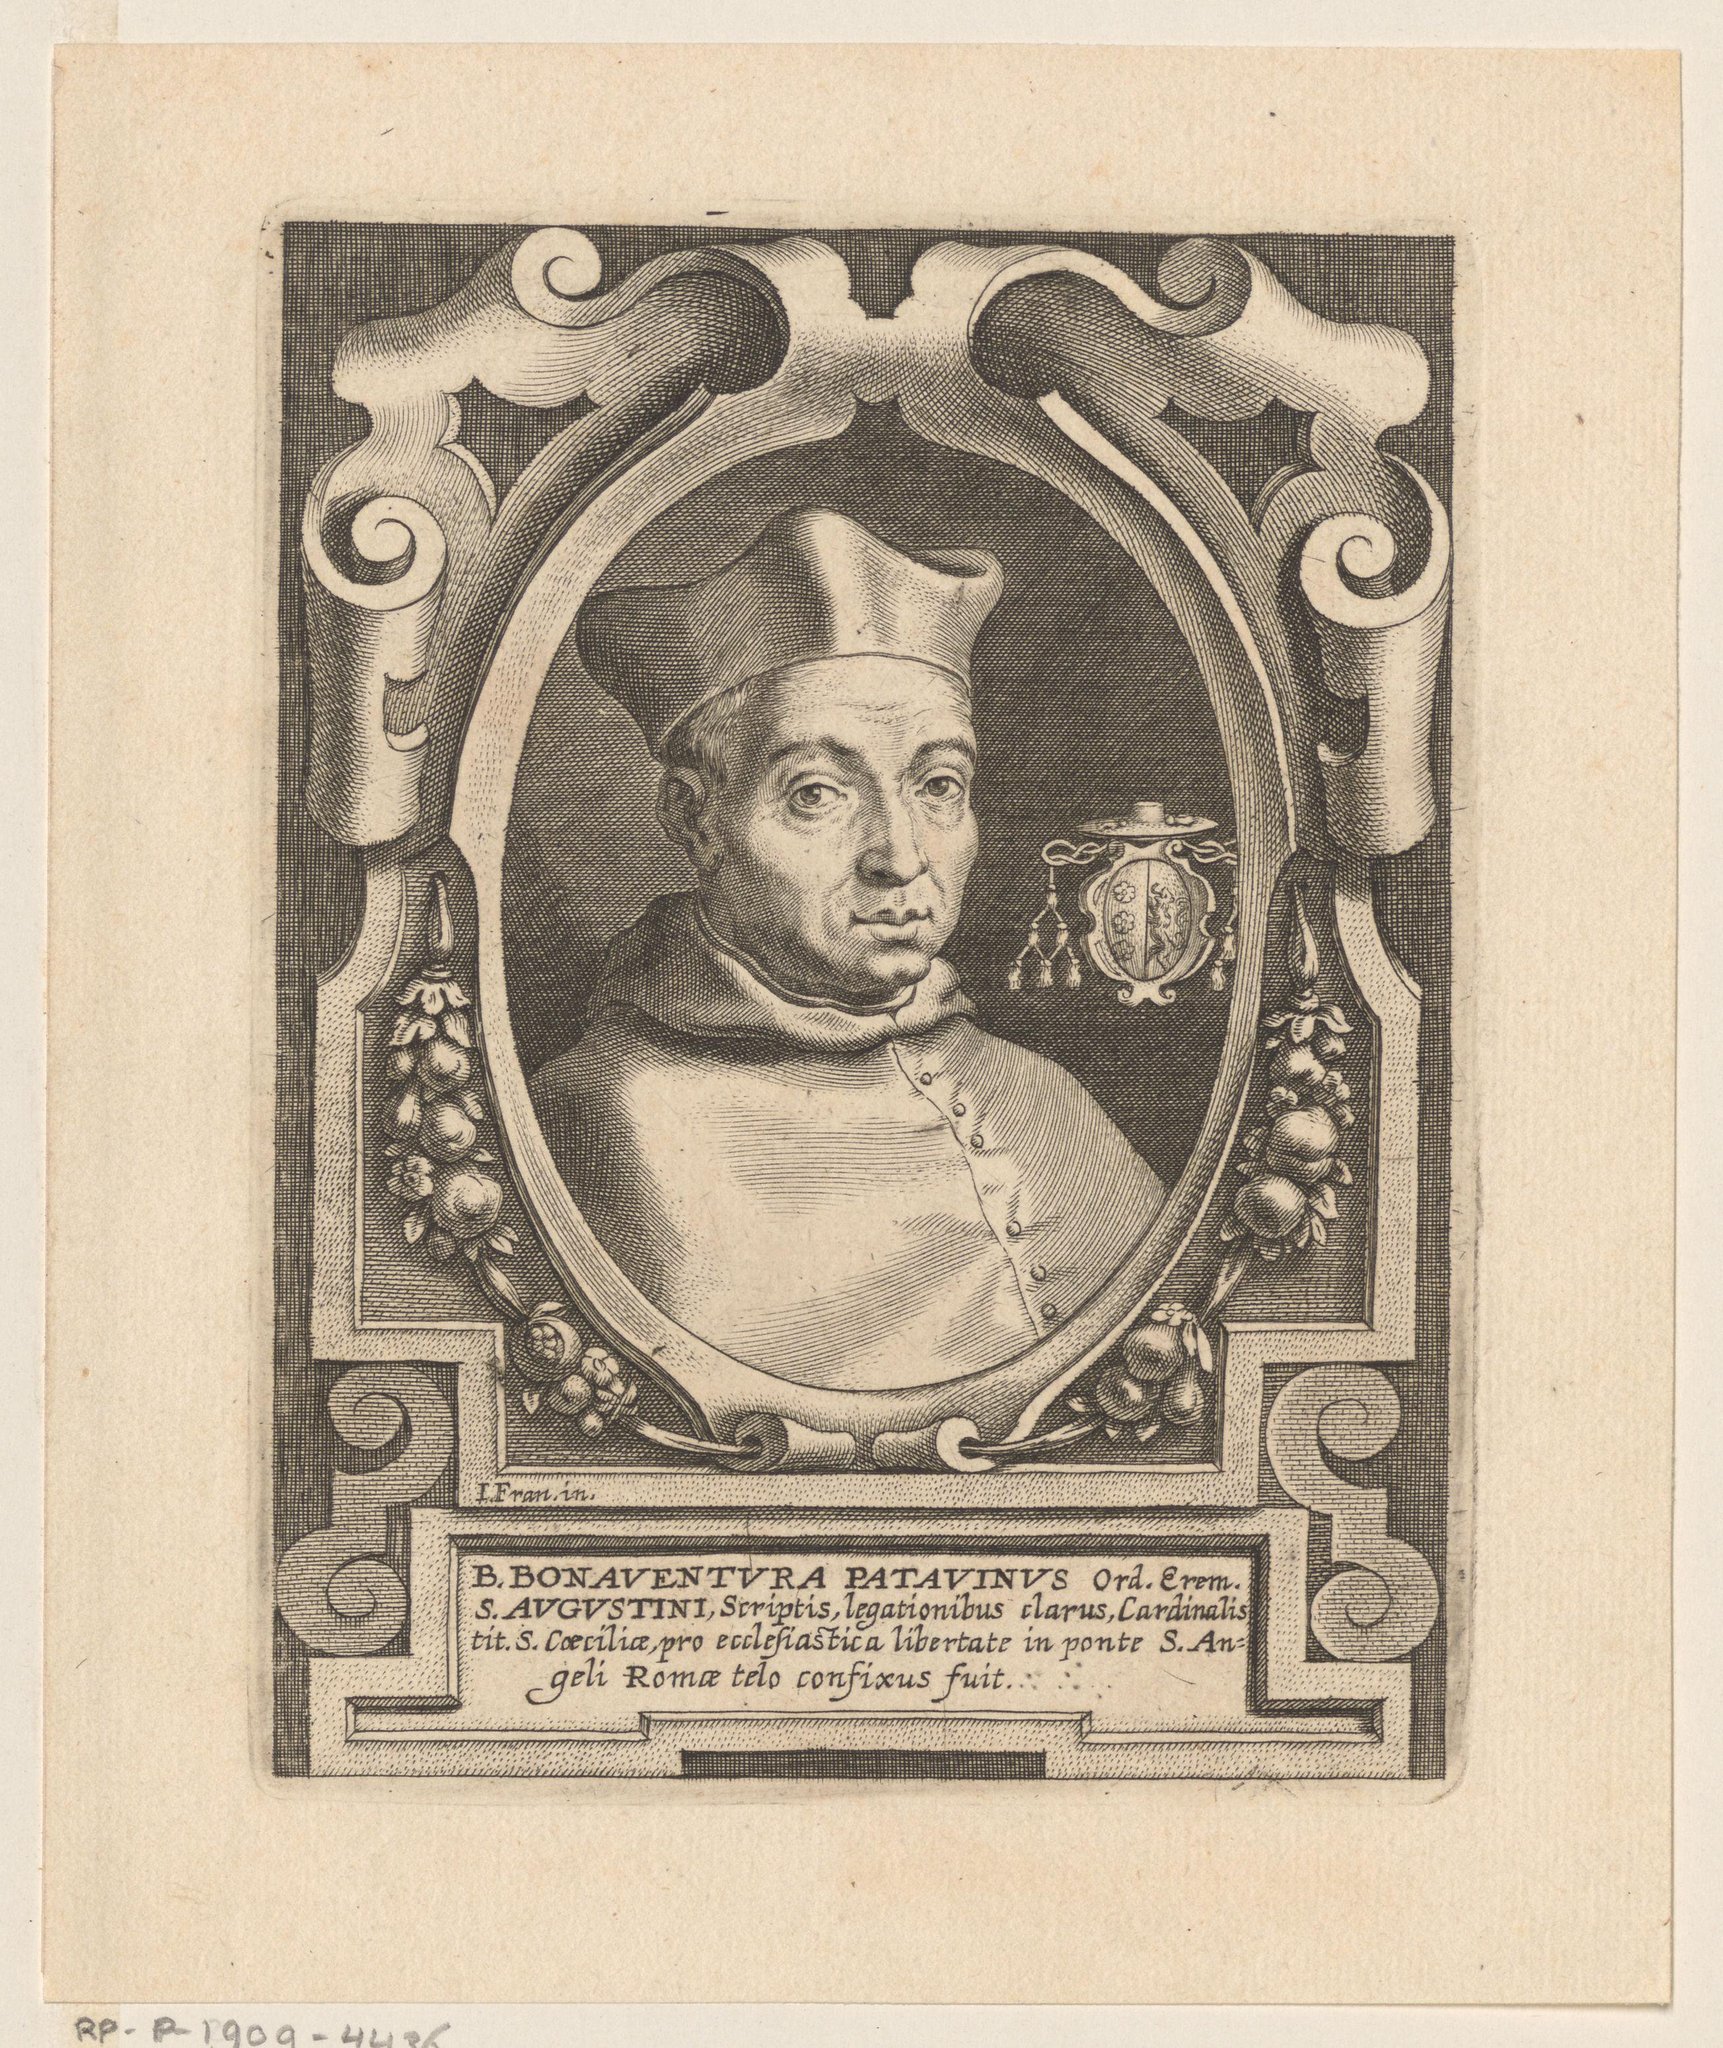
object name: print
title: Portret van kardinaal Bonaventura Bodoaro de Peraga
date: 1636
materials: paper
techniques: engraving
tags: rome, cardinal, historical persons, armorial bearing, heraldry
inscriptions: collector's mark: Lugt 2228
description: Prent met tekst op verso verschenen in: Curtius, Cornelius. Virorum illustrium ex ordine eremitarum D. Augustini elogia (...). Antwerpen: Johannes Cnobbaert, 1636.